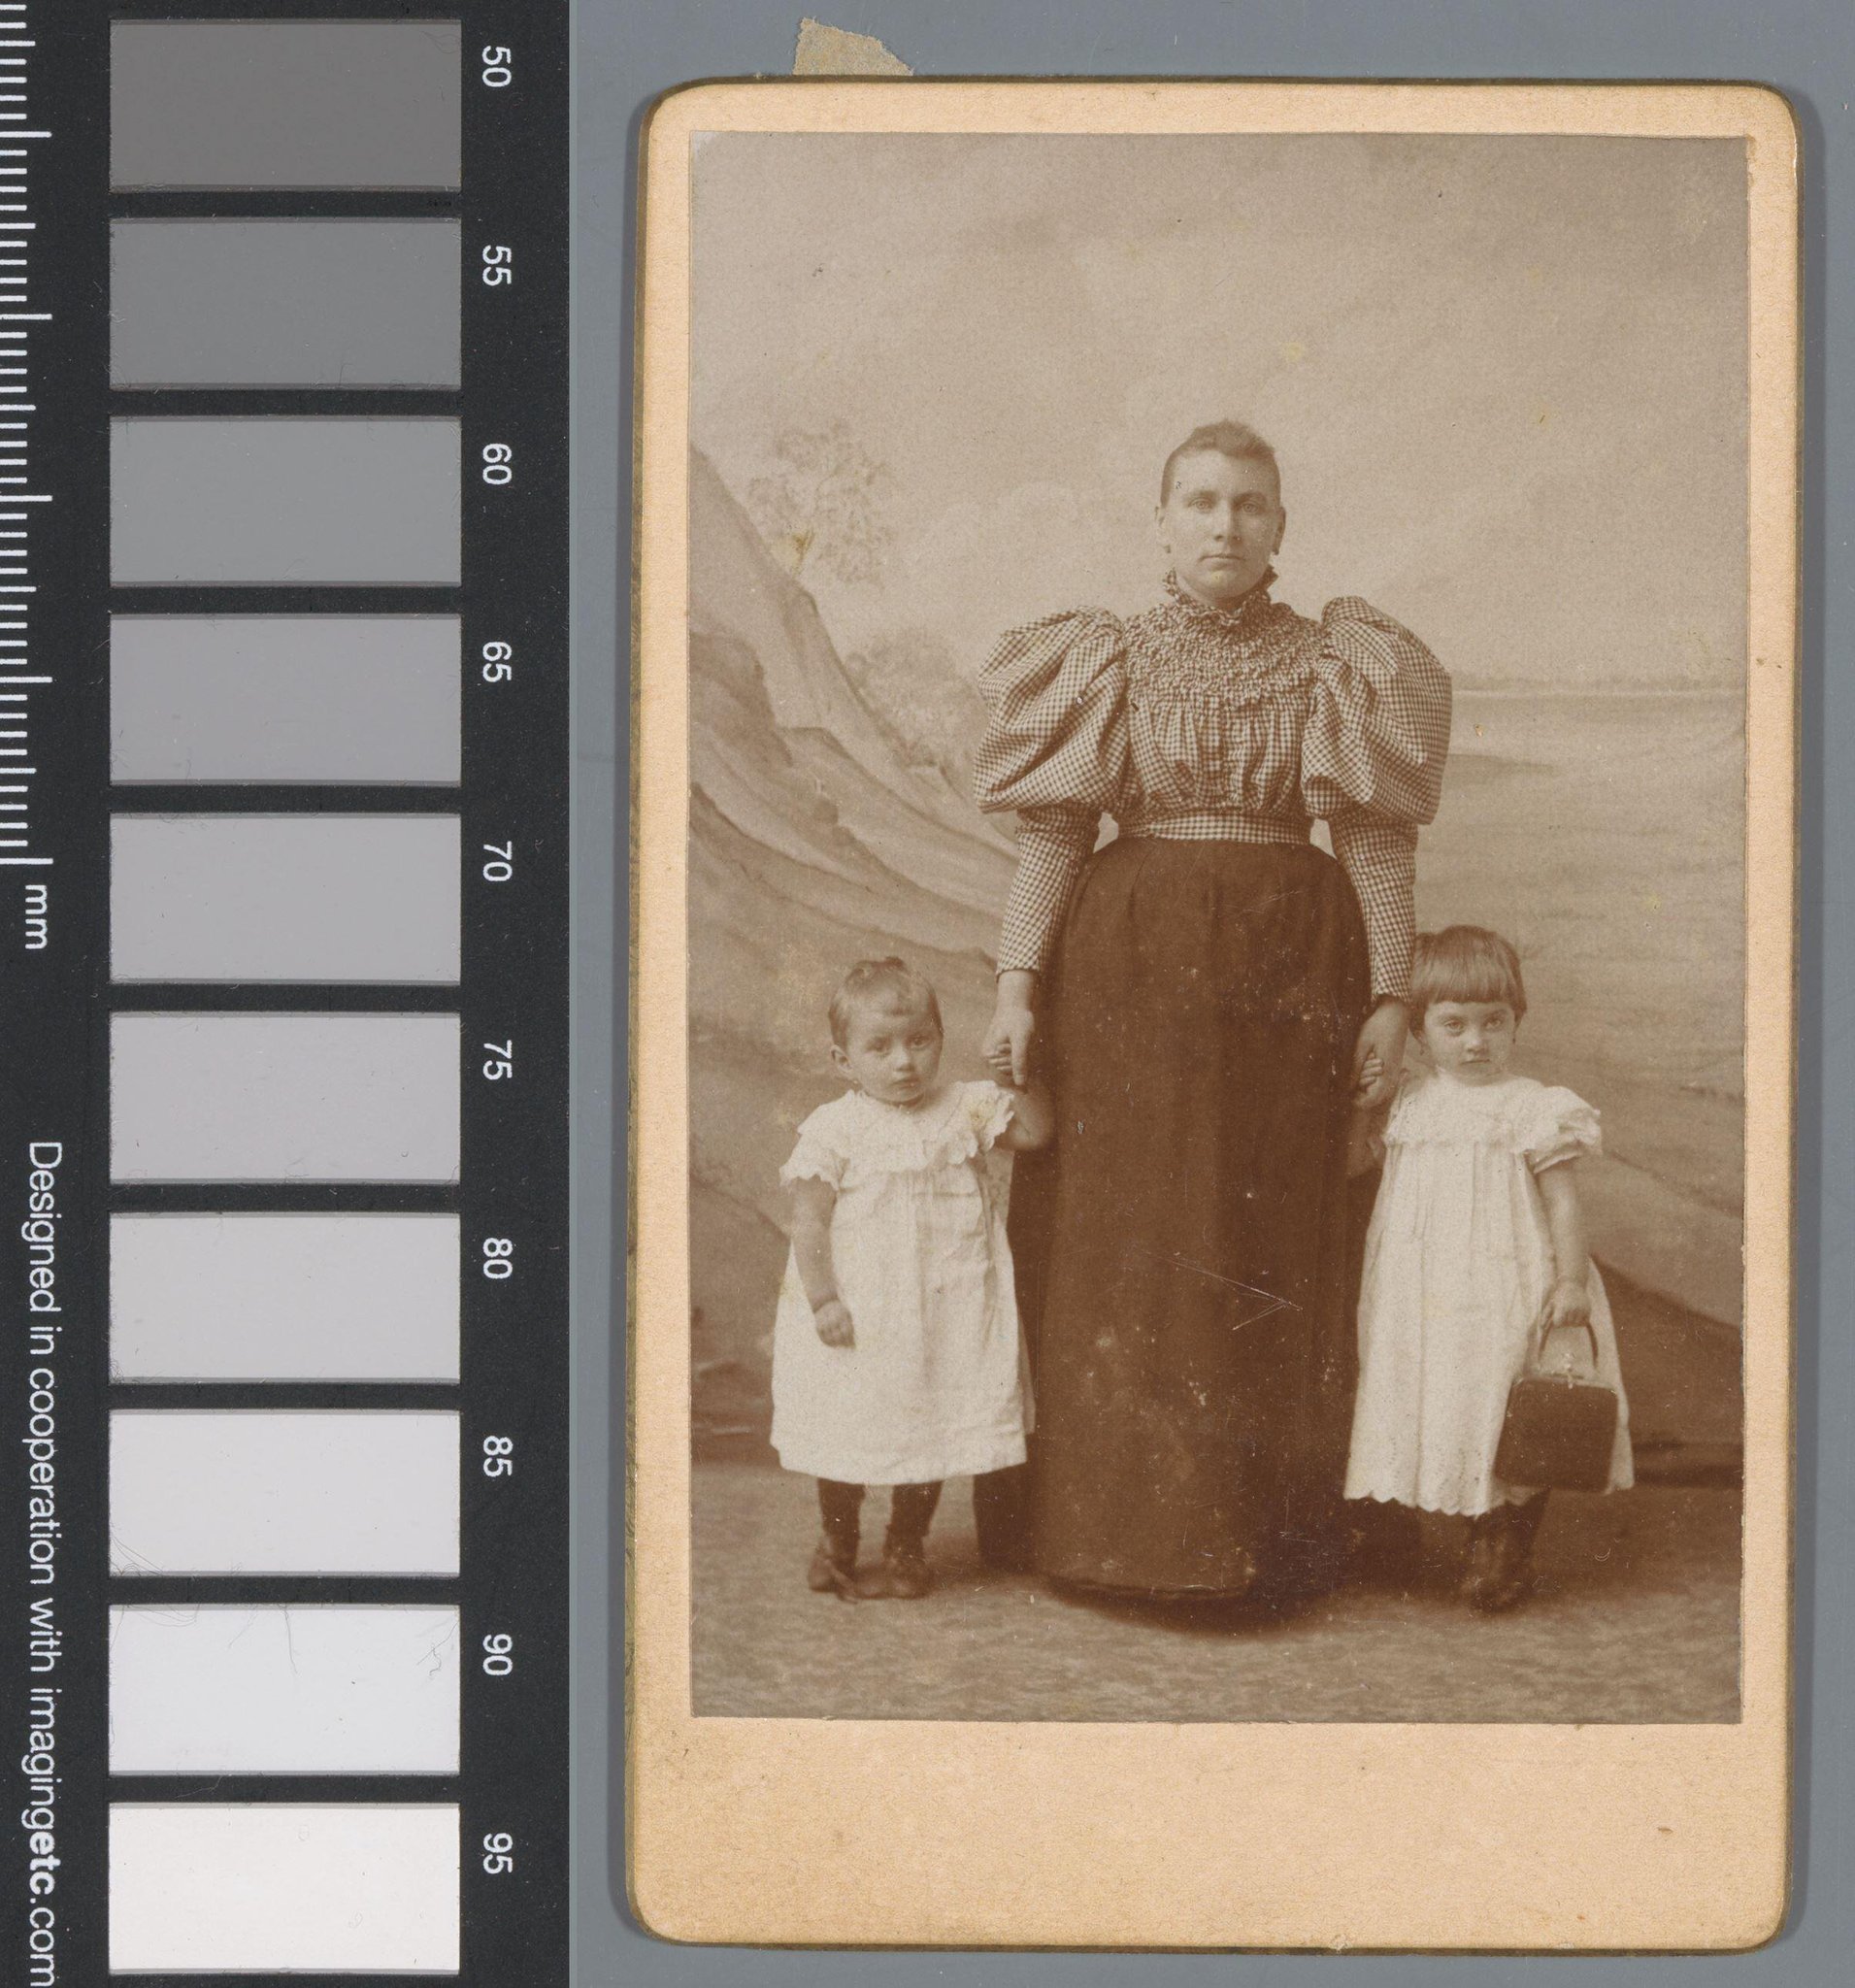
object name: photograph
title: Portret van een onbekende vrouw met twee meisjes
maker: Anonymous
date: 1900-1914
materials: paper, cardboard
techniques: collodion silver print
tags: adult woman, girl (child between toddler and youth), anonymous historical person portrayed